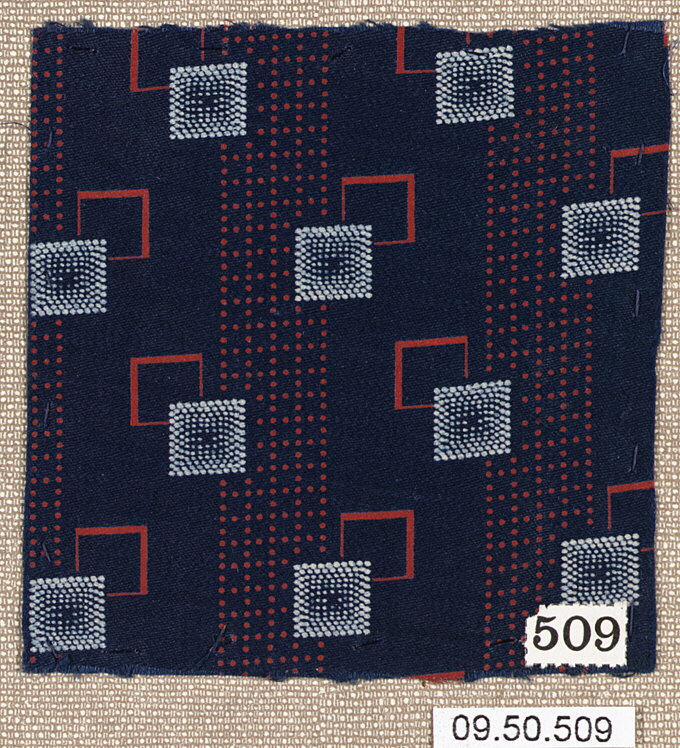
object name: piece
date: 1801-1900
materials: cotton